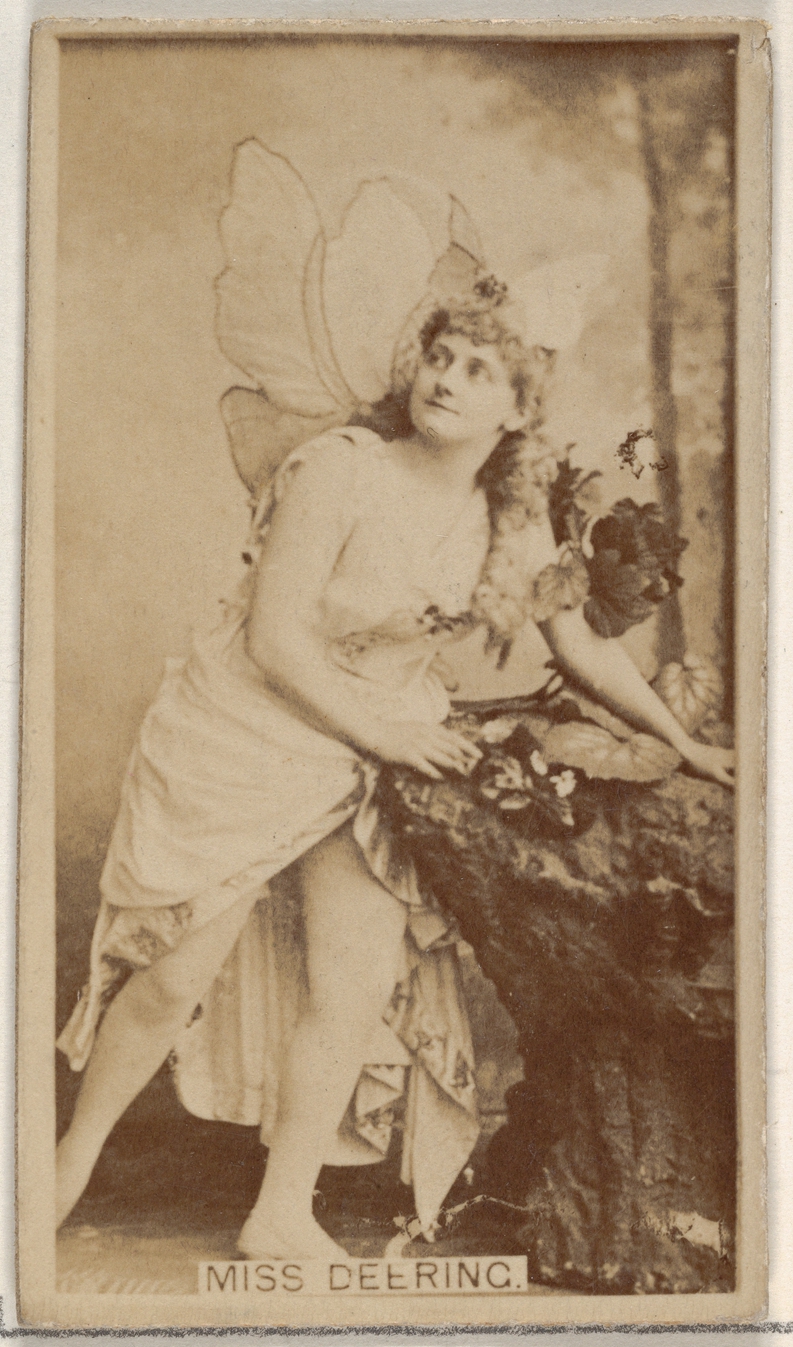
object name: photograph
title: Miss Deering, from the Actors and Actresses series (N45, Type 8) for Virginia Brights Cigarettes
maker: allen & ginter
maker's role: publisher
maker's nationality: american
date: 1888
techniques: albumen silver print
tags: portraits,women,actresses